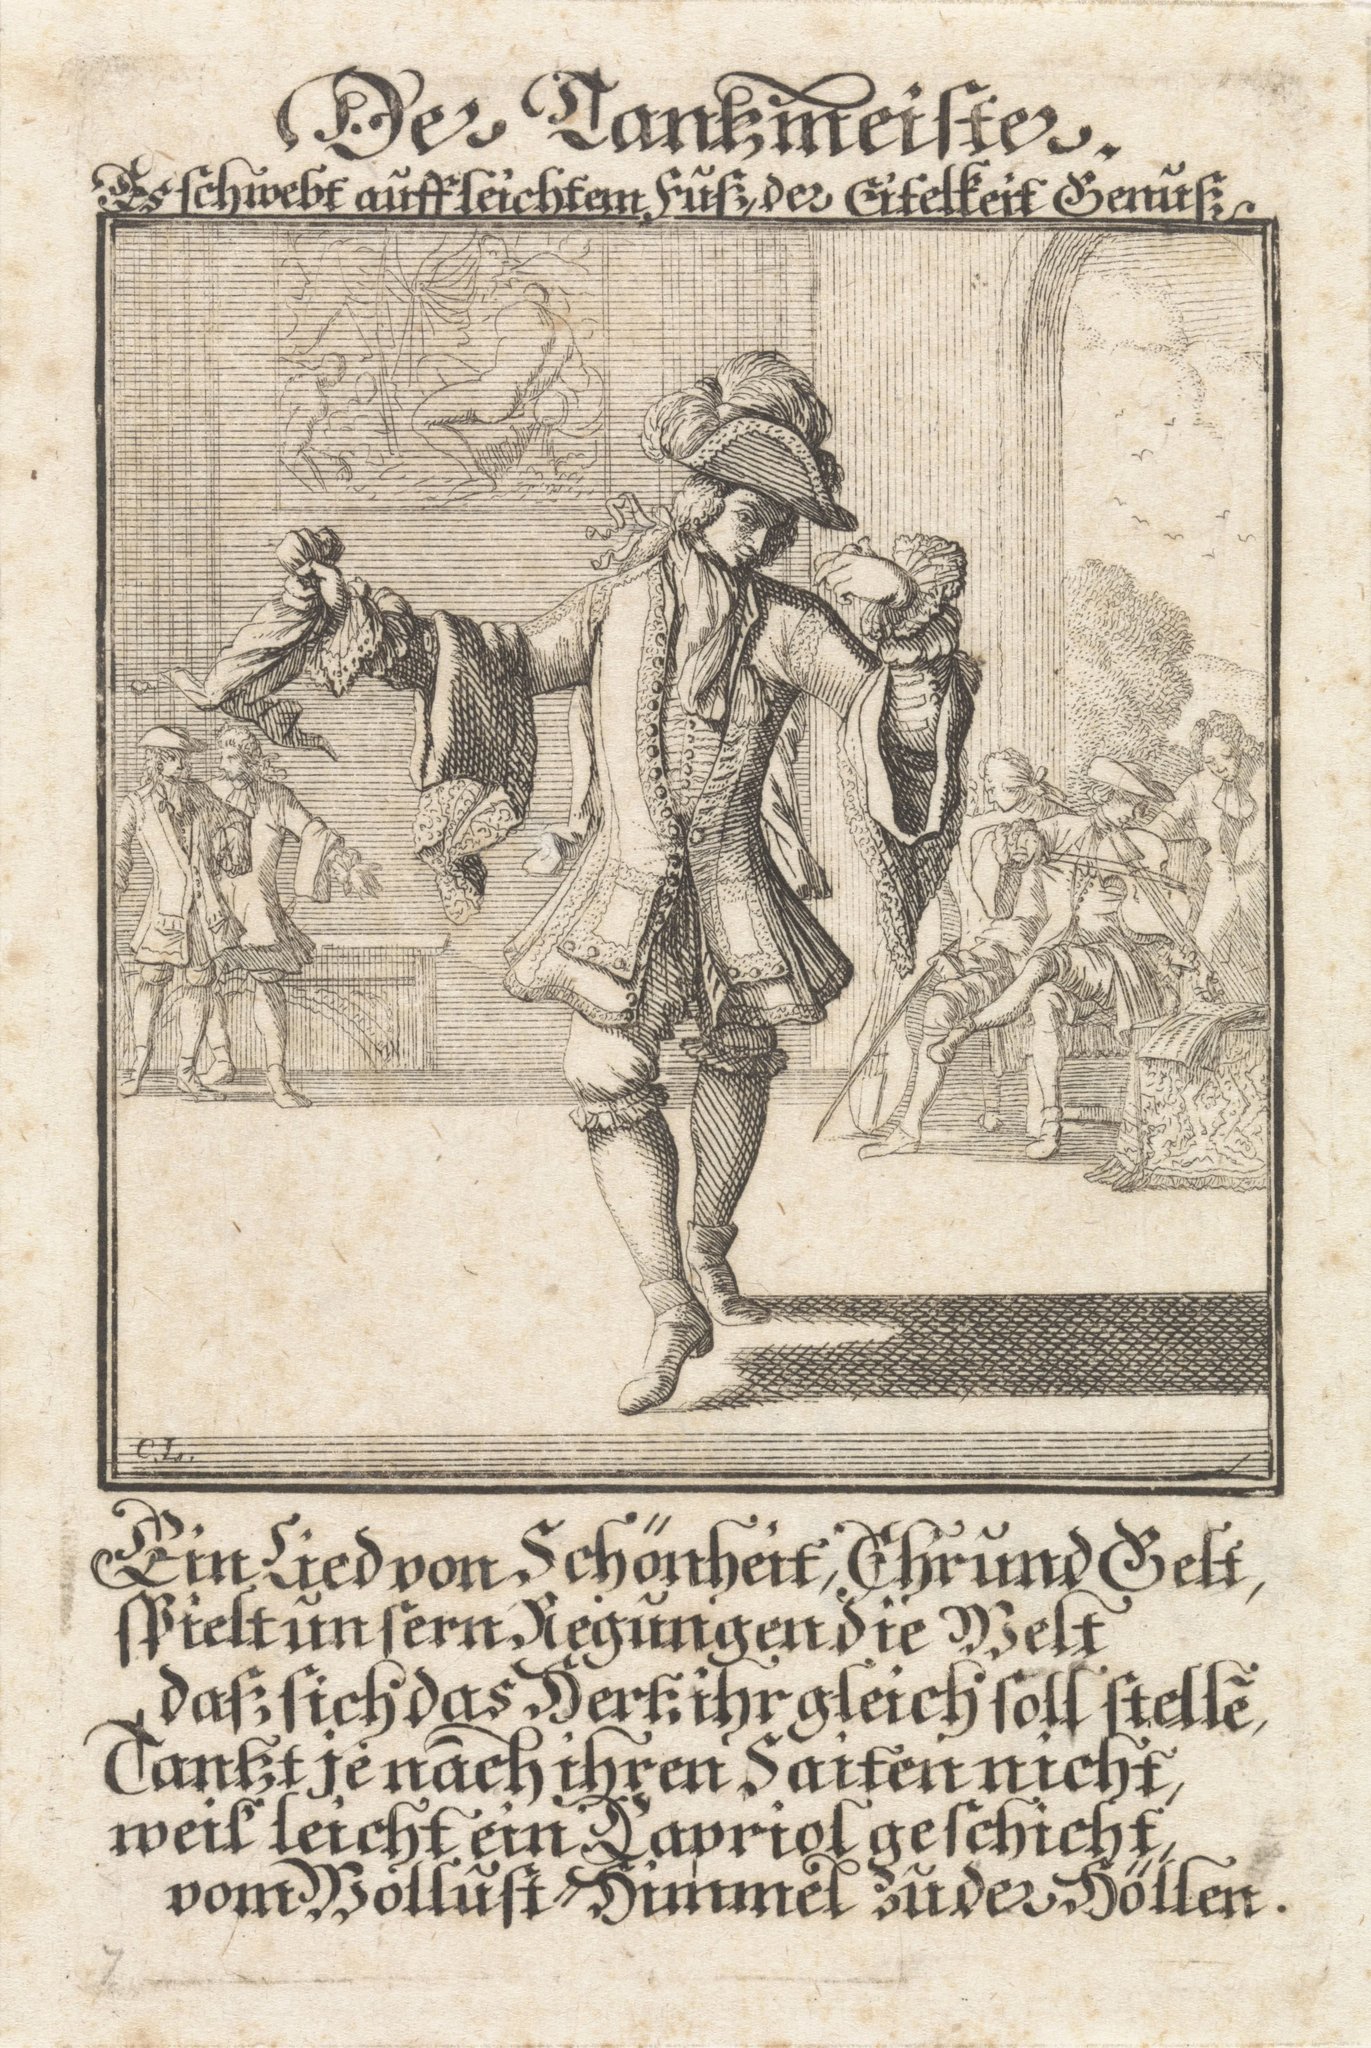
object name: book illustration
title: Der Tantzmeister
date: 1698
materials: paper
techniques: etching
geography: amsterdam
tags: man dancing alone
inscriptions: number: ‘7’, collector's mark: Lugt 2228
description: Illustratie uit: Weigel, Christoff. Abbildung Der Gemein-Nützlichen Haupt-Stände Von denen Regenten Und ihren So in Friedens- als Kriegs-Zeiten zugeordneten Bedienten an, biß auf alle Künstler Und Handwercker. Regenspurg 1698, p. 179.